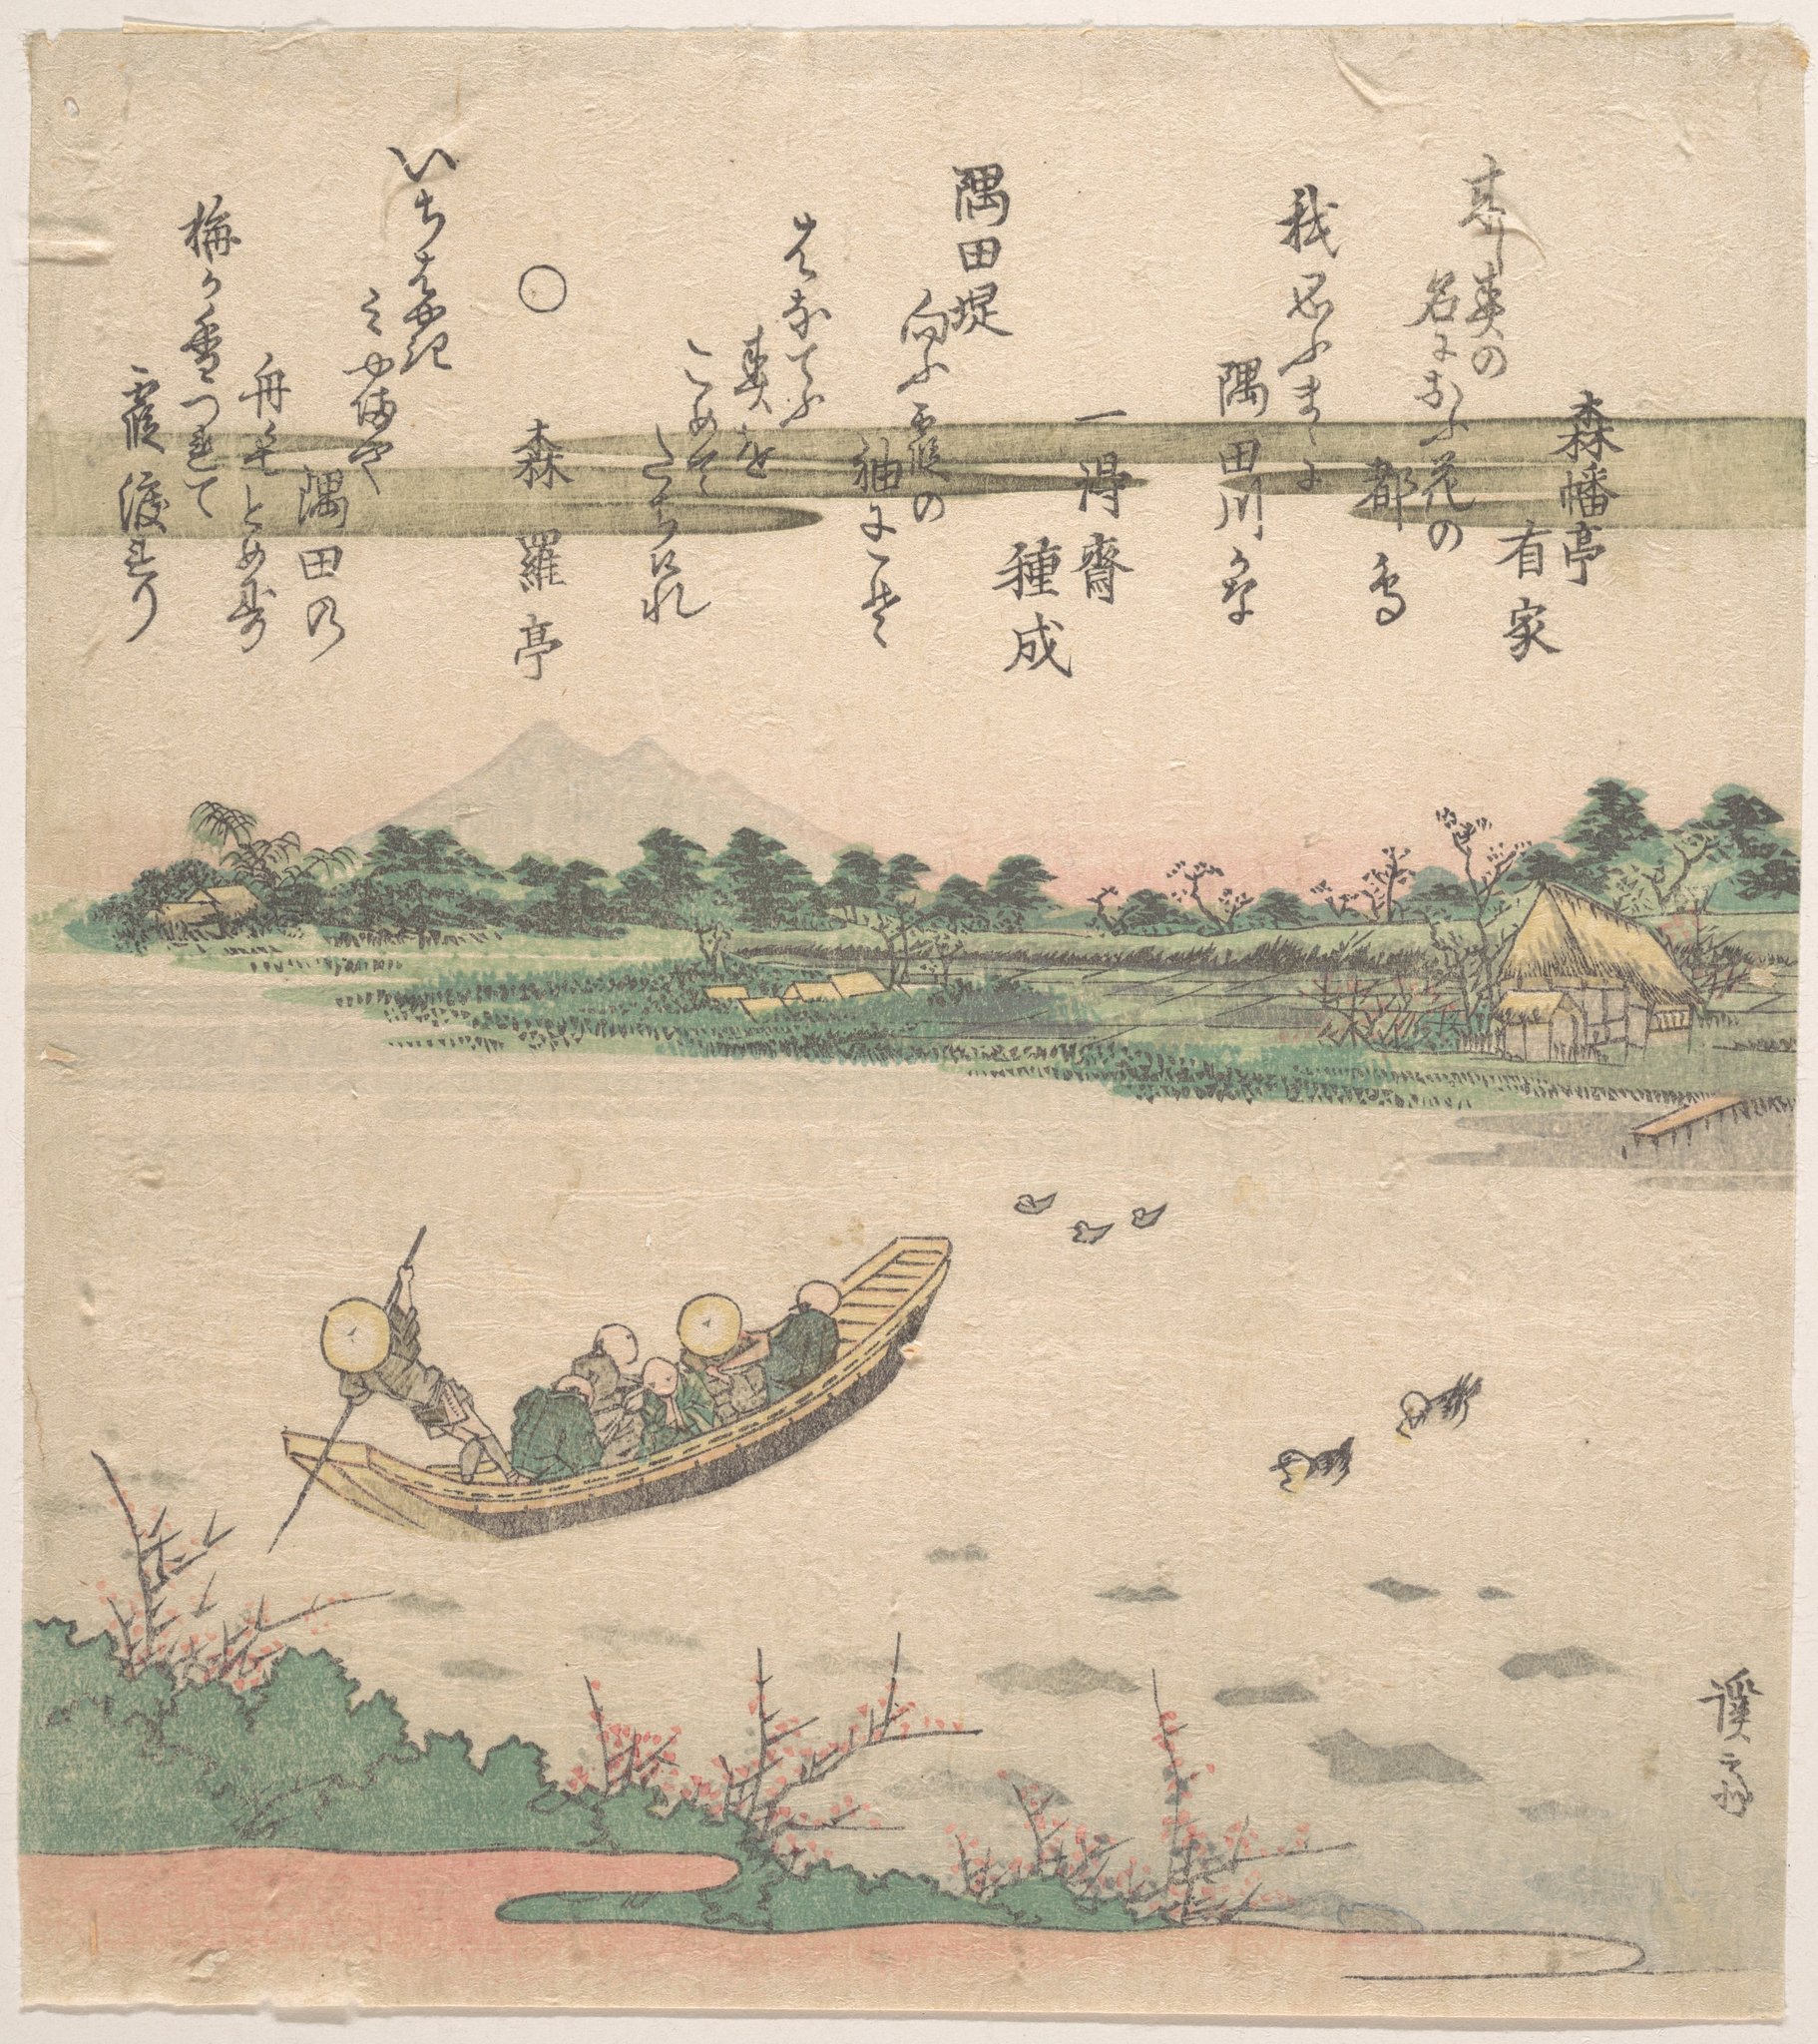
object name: print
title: Boat Ferrying Across River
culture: japanese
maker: keisai eisen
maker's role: artist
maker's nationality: japanese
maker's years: 1790-1848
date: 1790-1848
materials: ink, paper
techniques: surimono, woodblock print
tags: houses,men,rivers,trees,boats